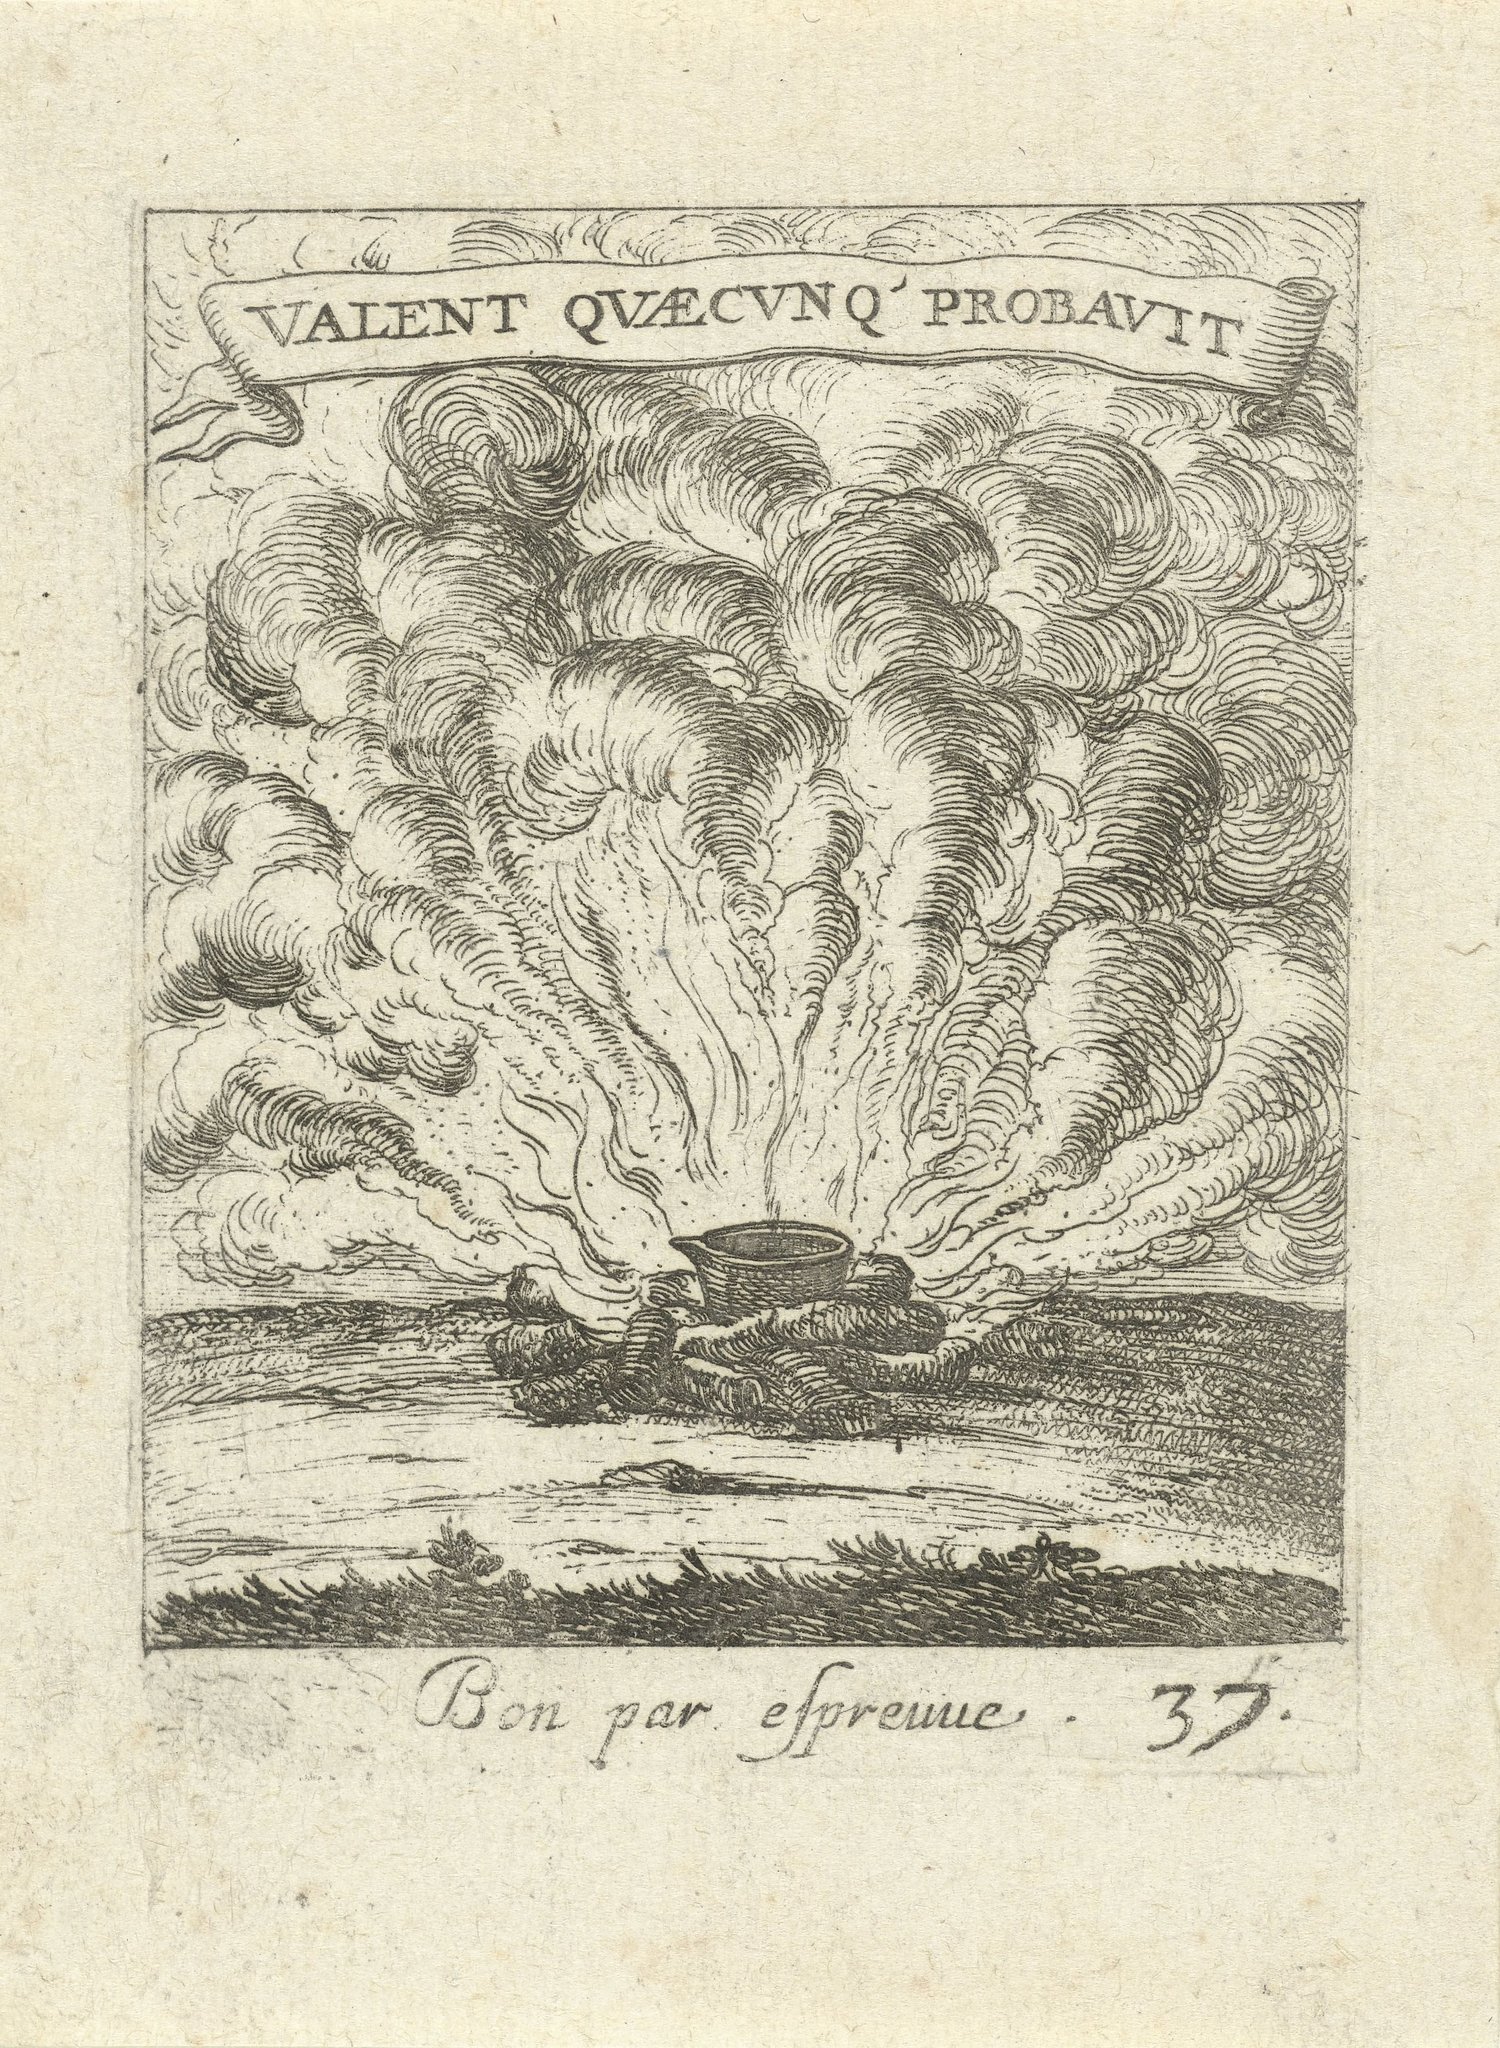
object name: print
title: Pan op een kampvuur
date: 1672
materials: paper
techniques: etching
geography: paris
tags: qualities of love: first series (+ emblematical representation of concept)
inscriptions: collector's mark: Lugt 2166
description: Een pan op een kampvuur met hoge vlammen en rookwolken. Op een banderol een devies in Latijn en een onderschrift in Frans, beide over de liefde.